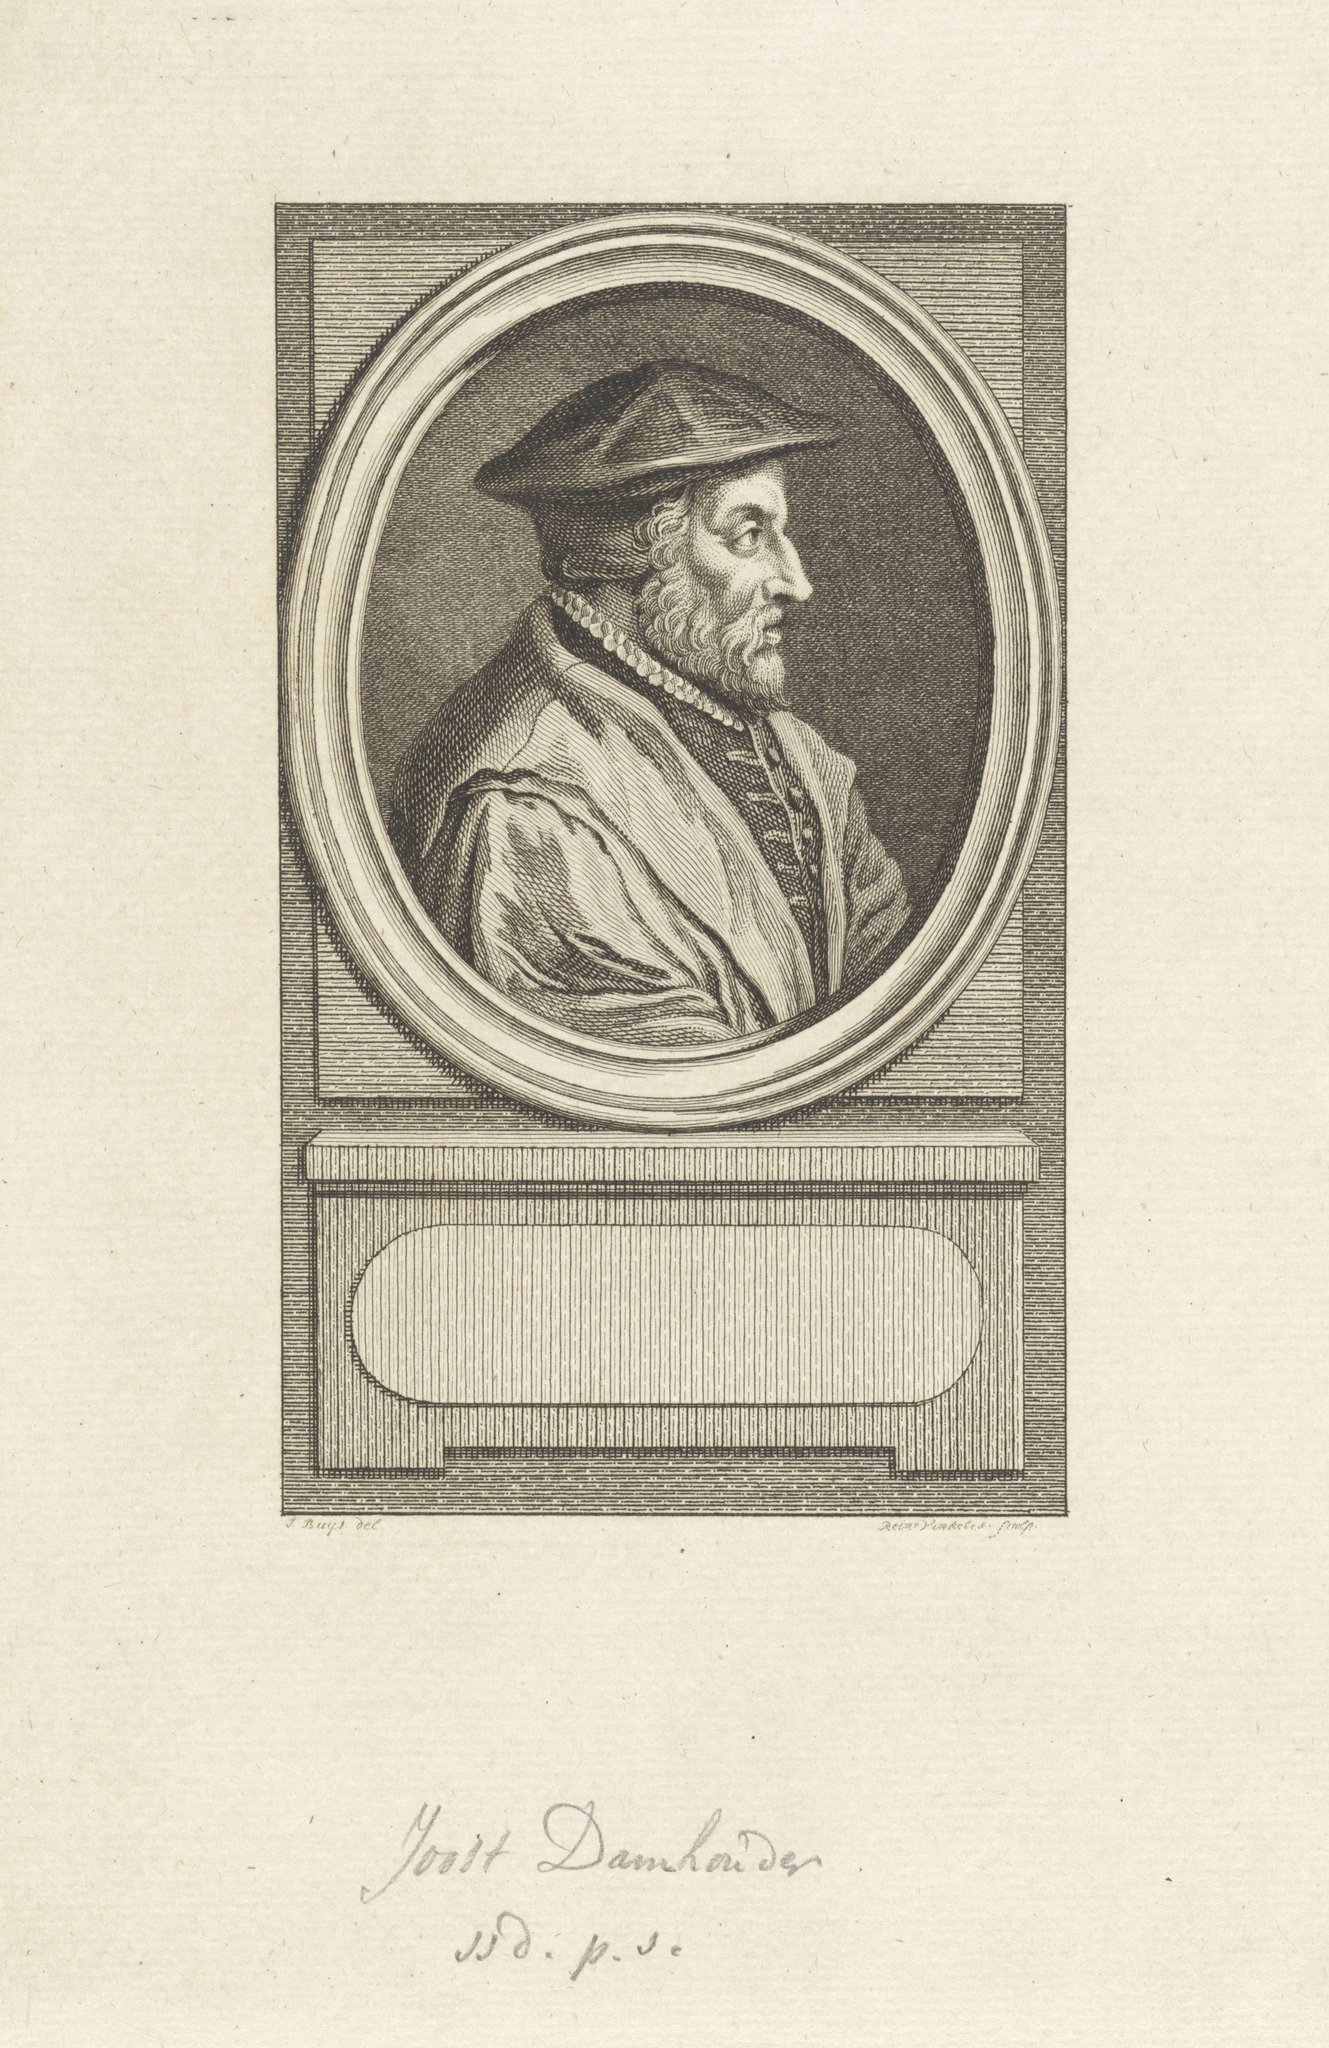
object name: print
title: Portret van Joos de Damhouder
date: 1788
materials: paper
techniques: etching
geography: amsterdam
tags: bruges, antwerp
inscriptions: collector's mark: Lugt 240, inscription: ‘Joost Damhouder 11 d. p. 1.’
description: Latere staat prent gebruikt als boekillustratie in: Kok, Jacobus. Vaderlandsch woordenboek : met kaarten, plaaten en pourtraitten. Amsterdam: Johannes Allart, 1785-1796. Deel XI.